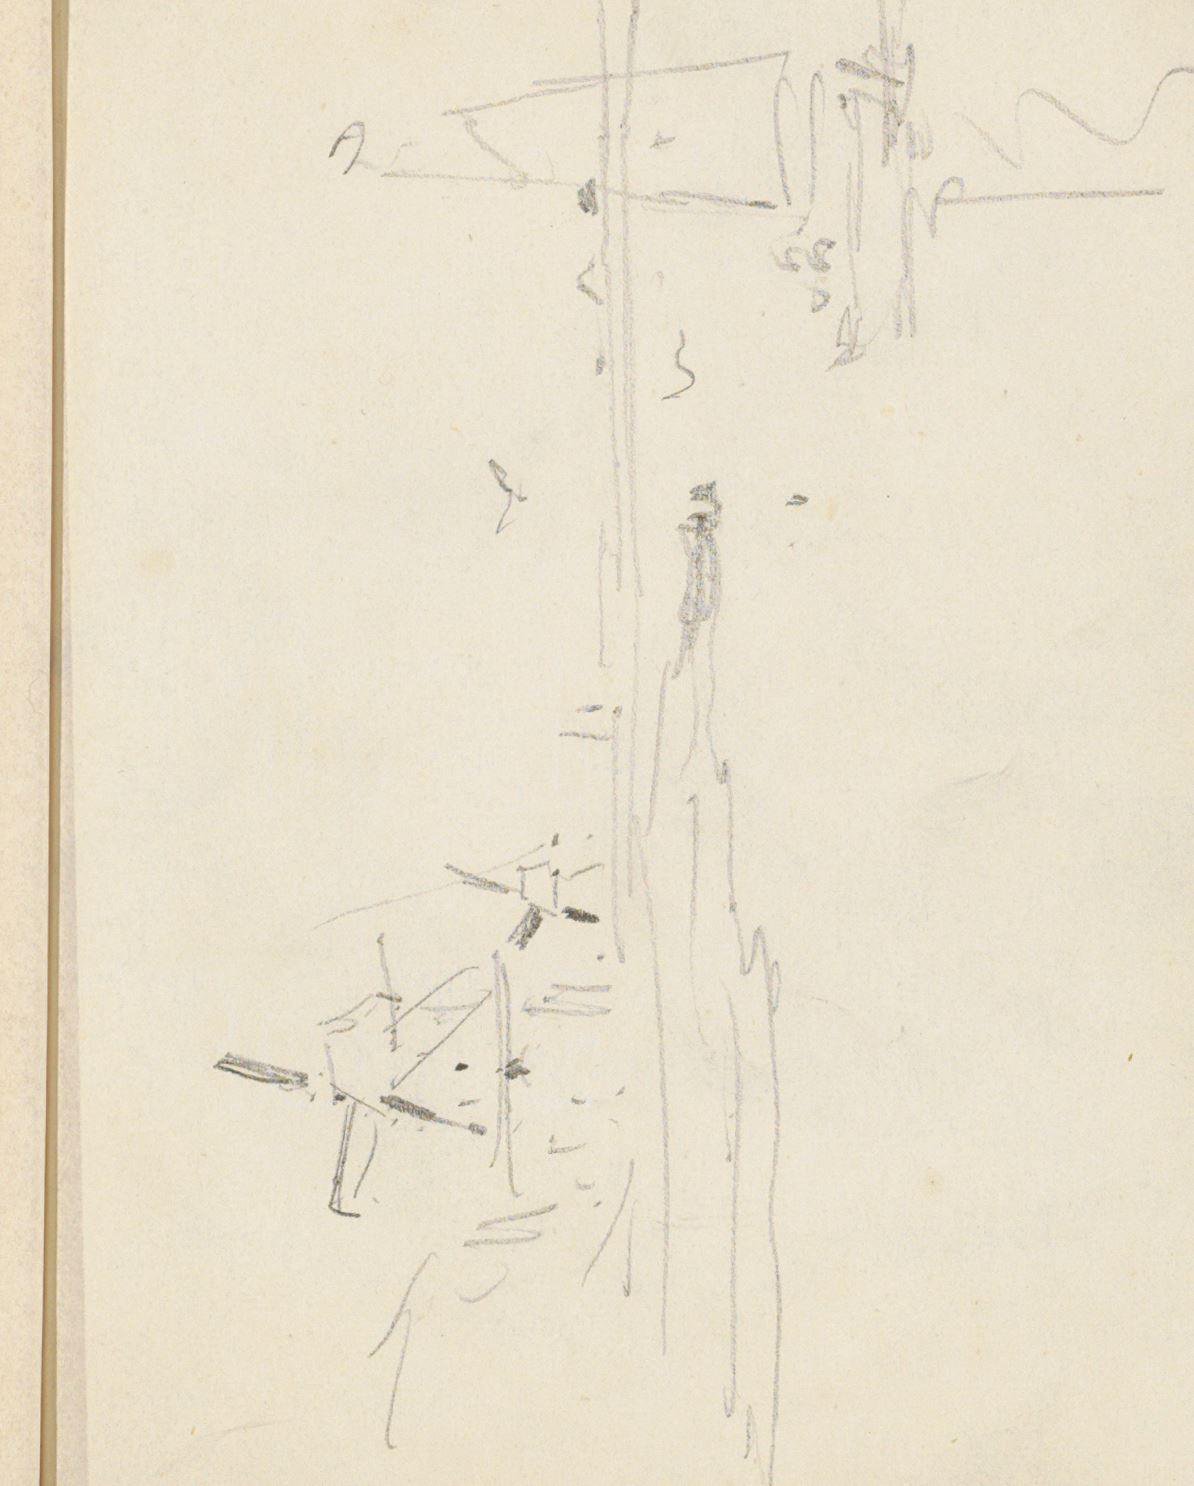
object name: sketchbook leaf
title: Molens langs het Markermeer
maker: alfred william rich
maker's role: draughtsman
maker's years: 1856-1921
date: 1892-1893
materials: paper, pencil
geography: marken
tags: sailing-ship, sailing-boat, lake, windmill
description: Blad 41 recto uit een schetsboek met 86 bladen.